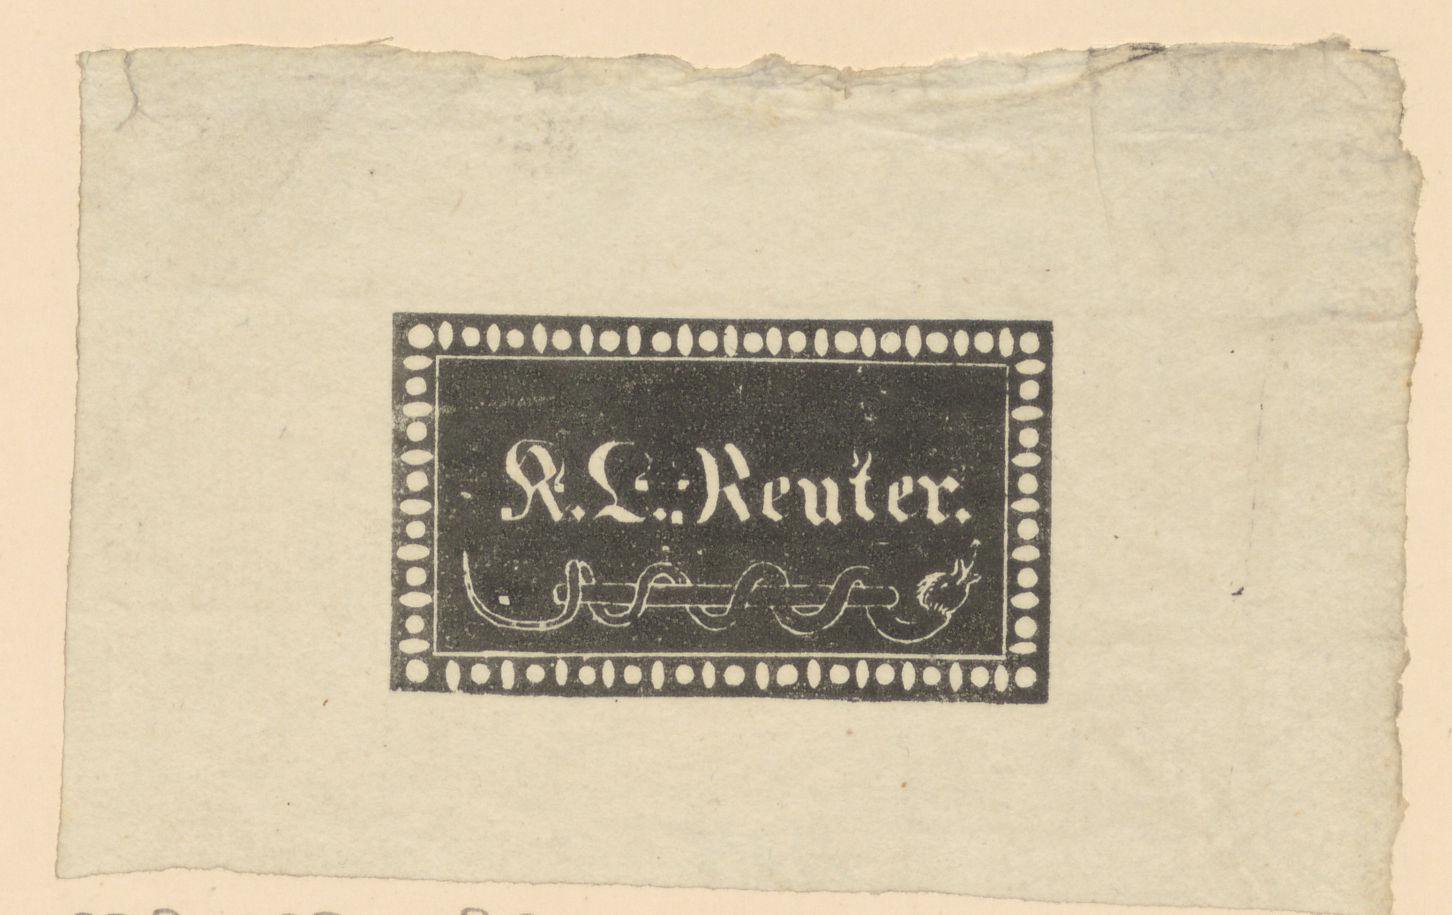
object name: print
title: Vignet met de naam Reuter en een esculaap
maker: friedrich wilhelm reuter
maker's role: print maker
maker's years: 1768-1834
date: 1778-1834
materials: paper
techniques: lithograph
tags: aesculapian sign